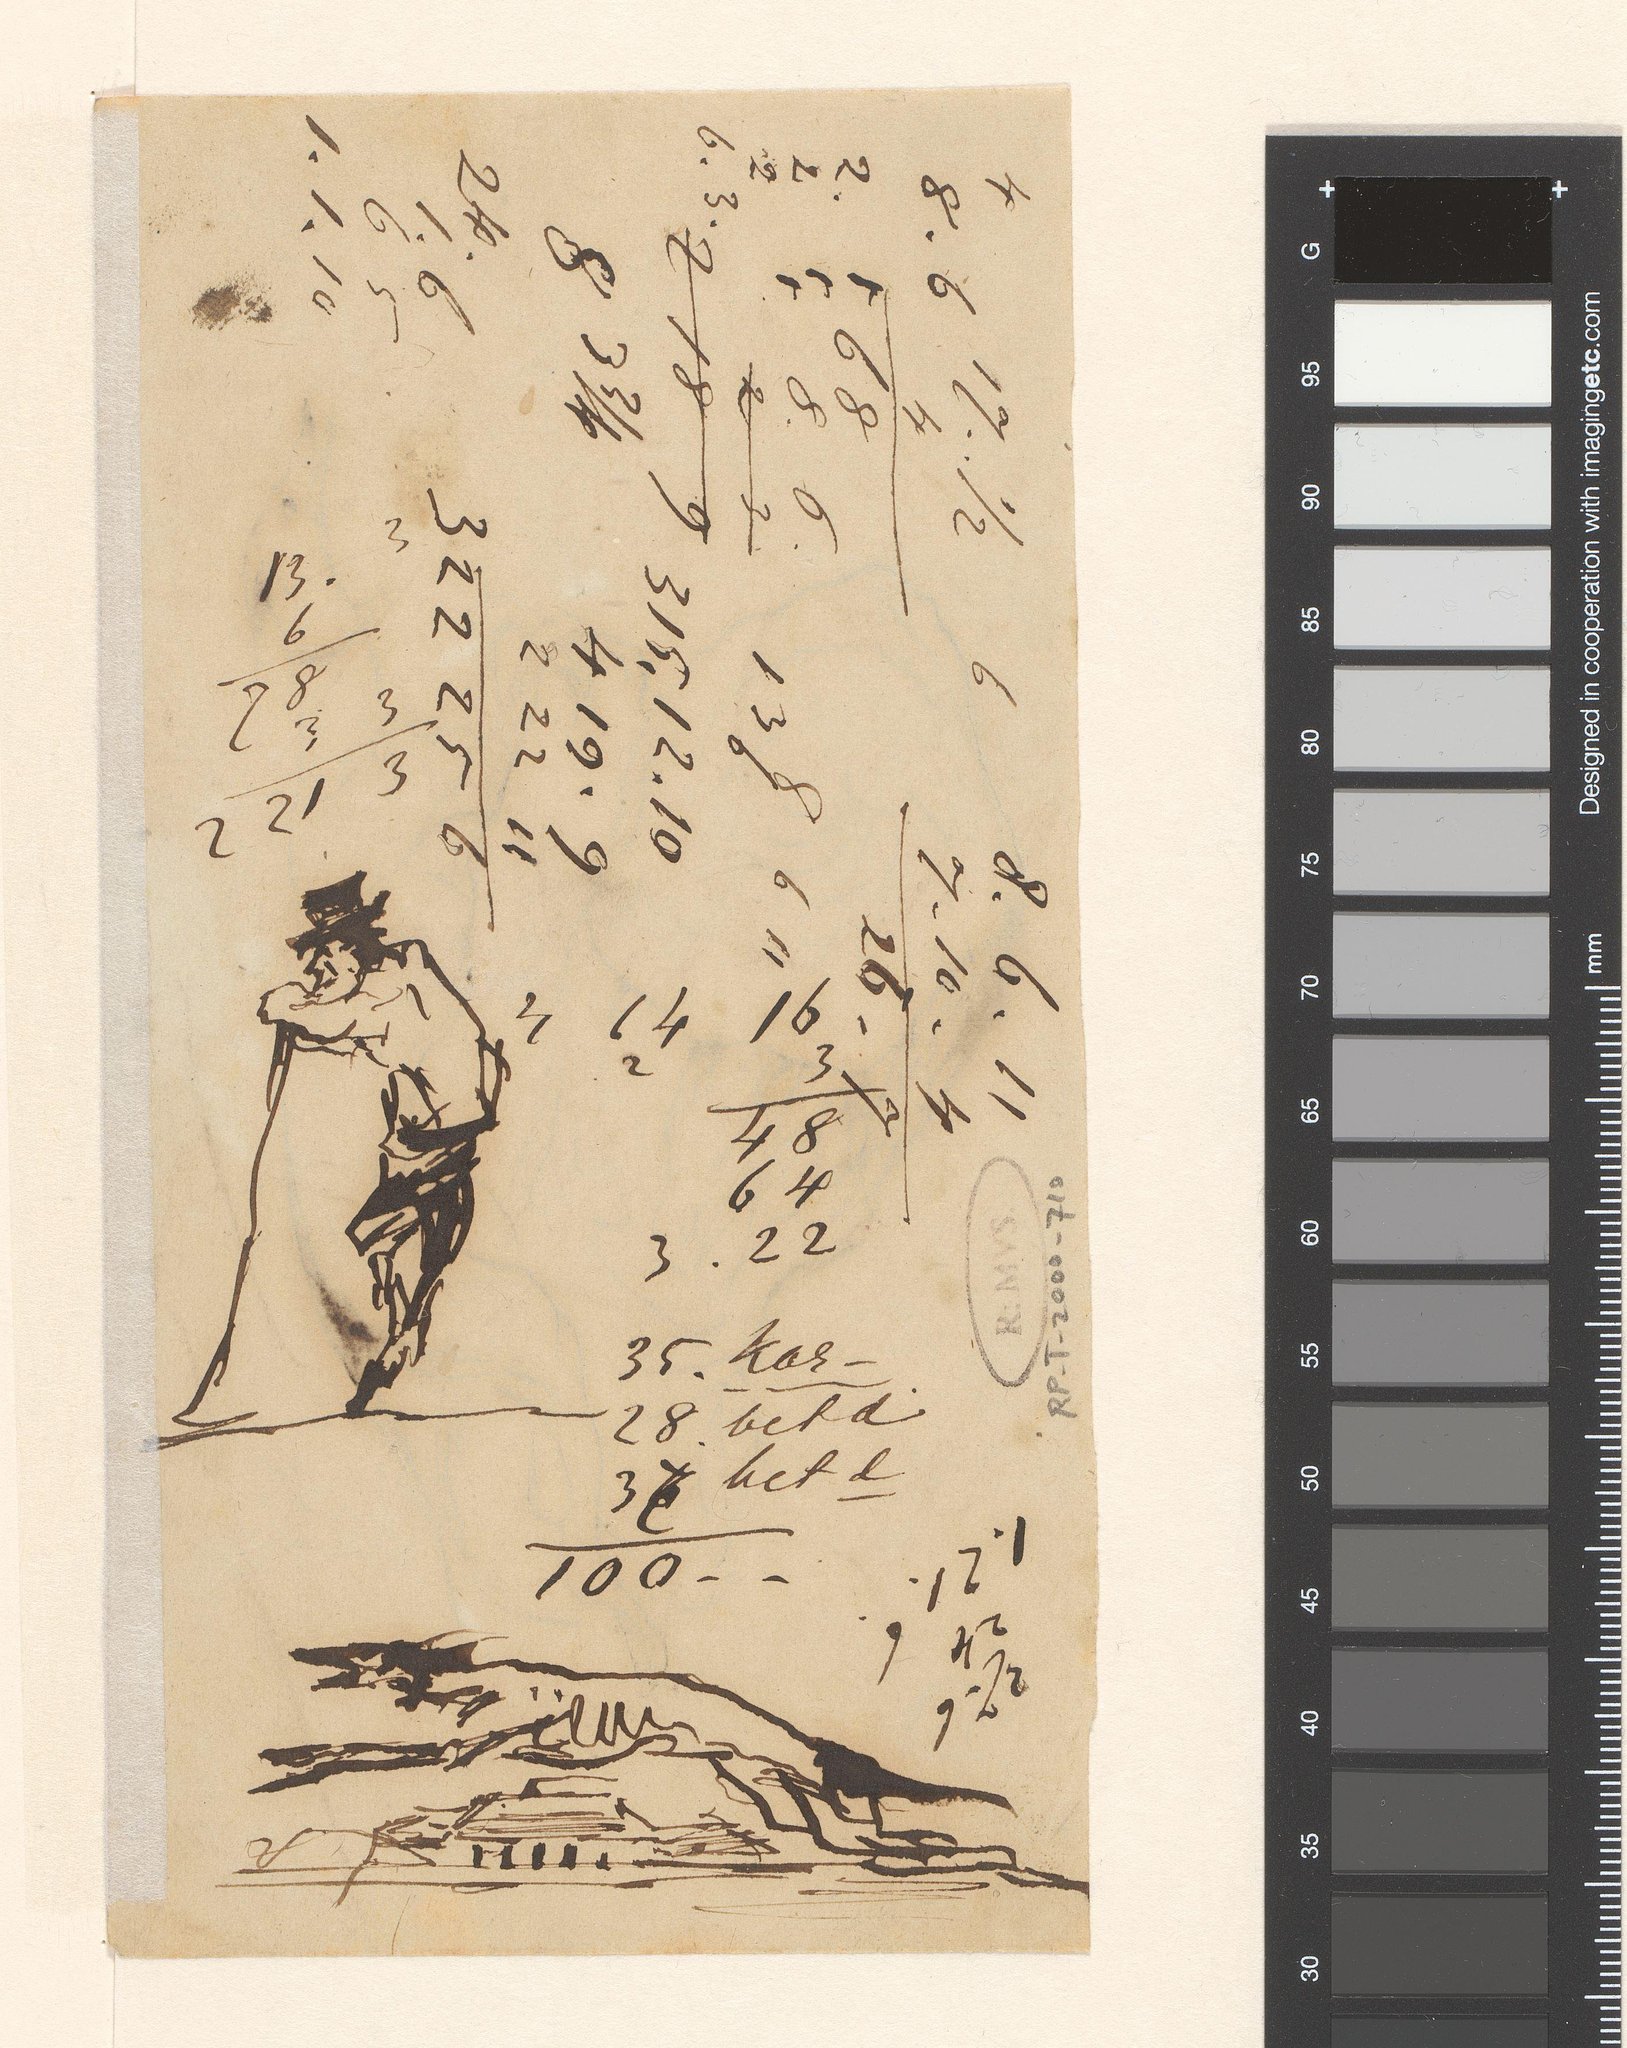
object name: drawing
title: Springend jachthond en staande man met stok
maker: johannes tavenraat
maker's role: draughtsman, painter, print maker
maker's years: 1809-1881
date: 1840-1880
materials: ink, paper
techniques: pen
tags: hunting dogs, dog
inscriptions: collector's mark: Lugt 2228